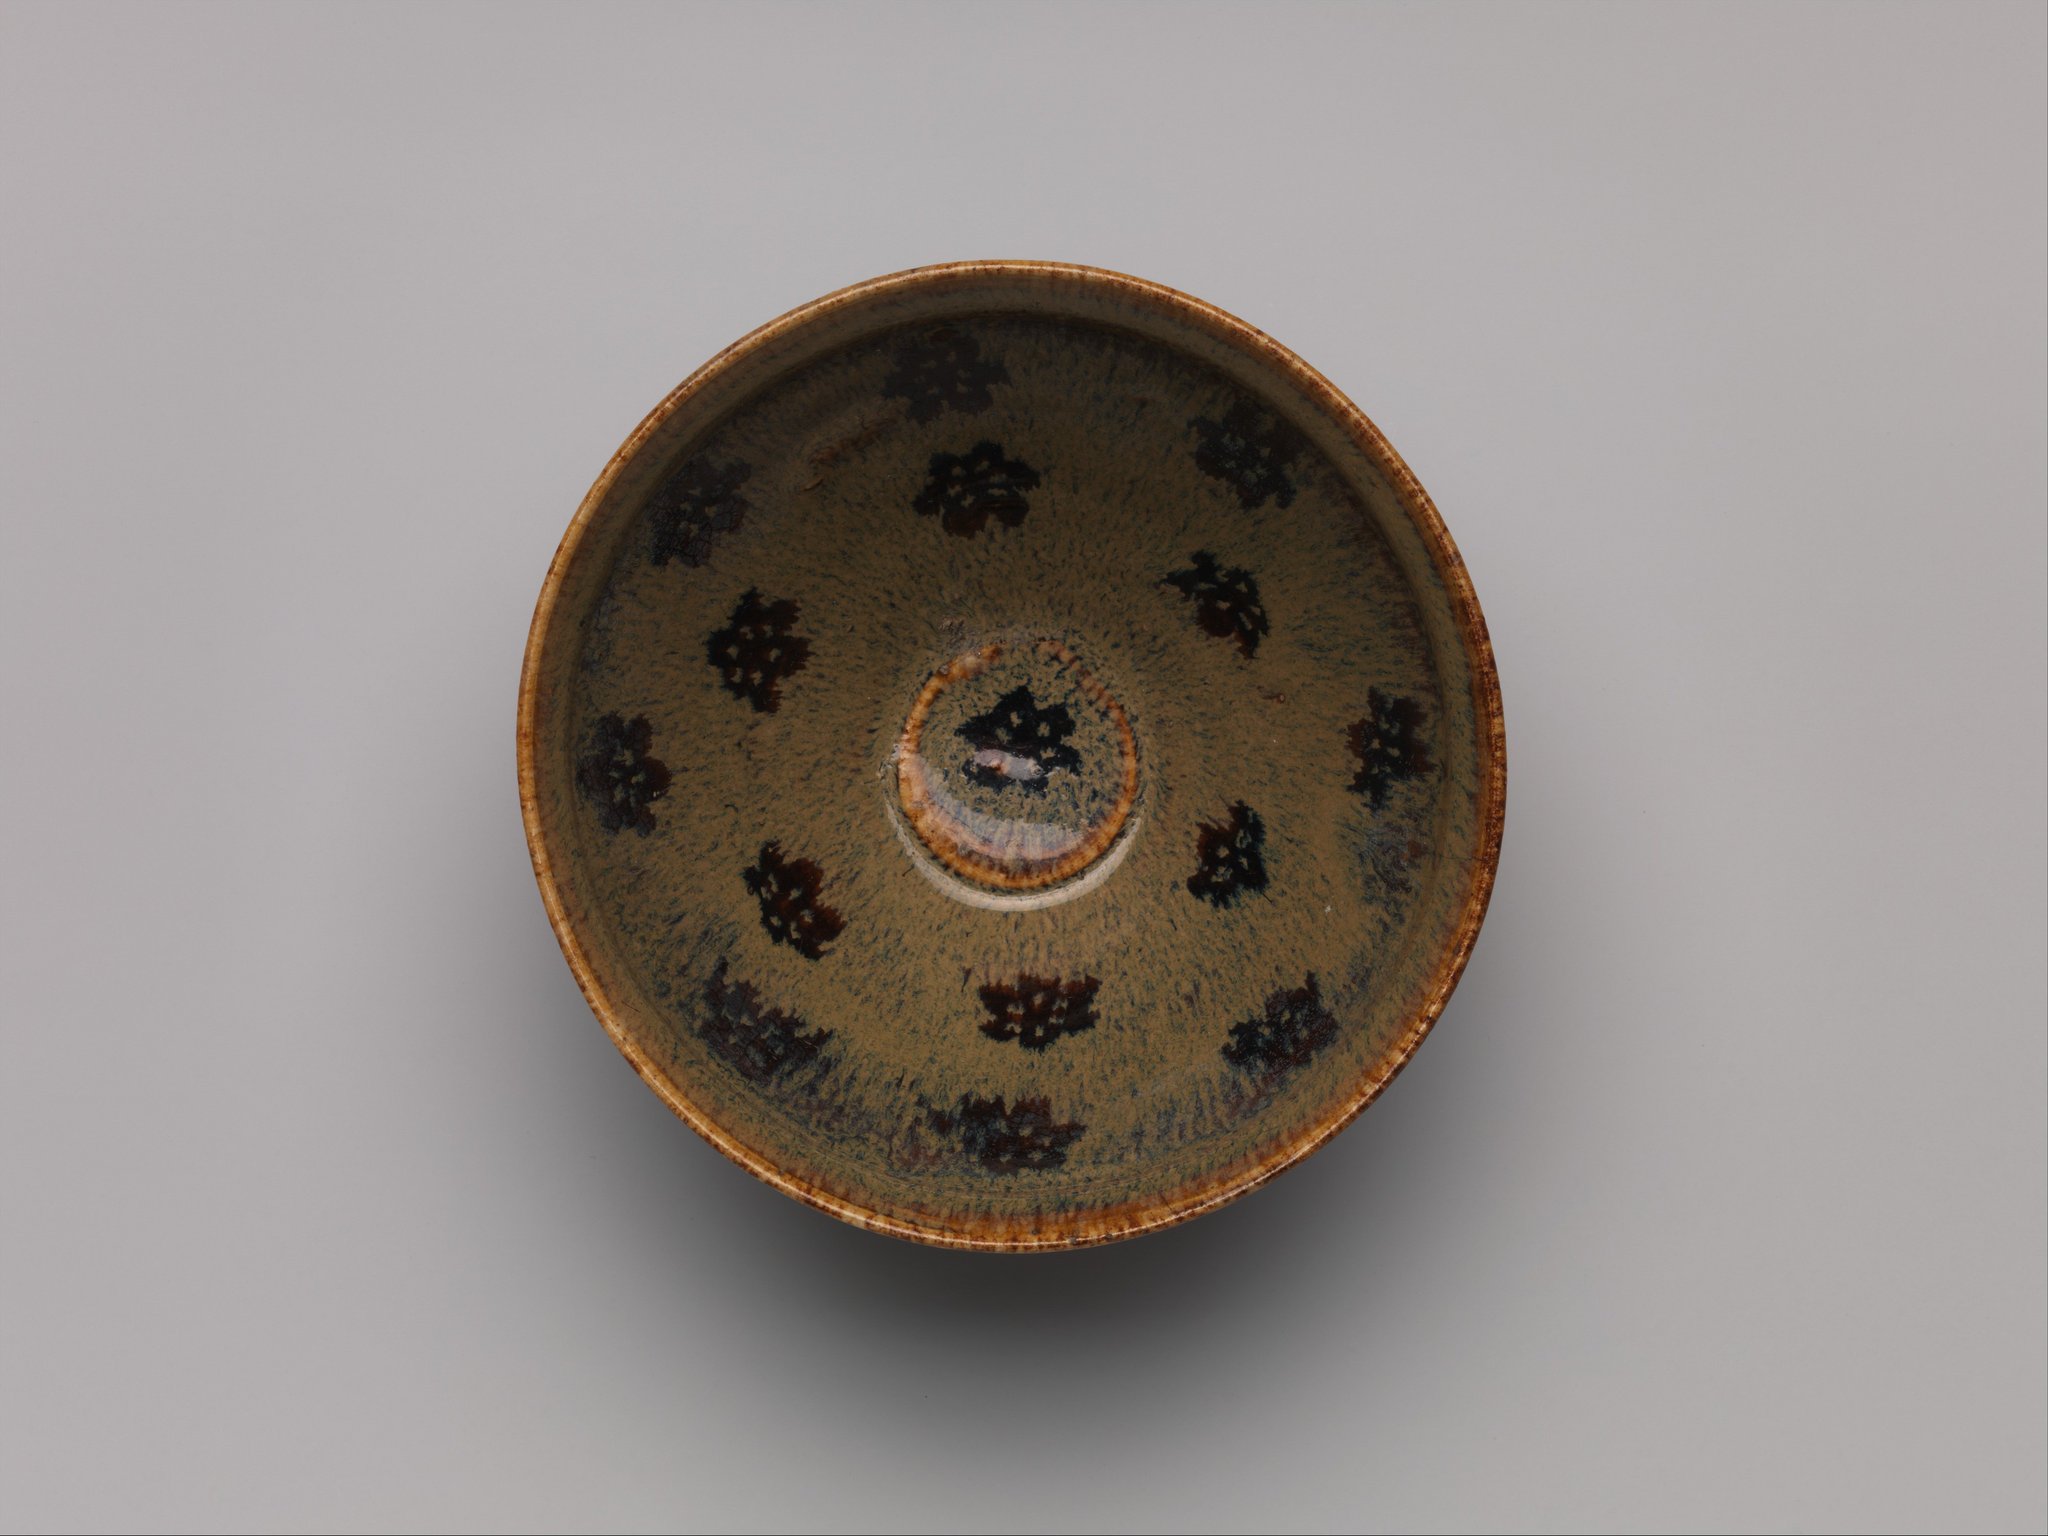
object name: bowl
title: Tea bowl with decoration of six-petaled flowers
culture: chinese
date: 1101-1300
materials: glaze, paper, stoneware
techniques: cutting